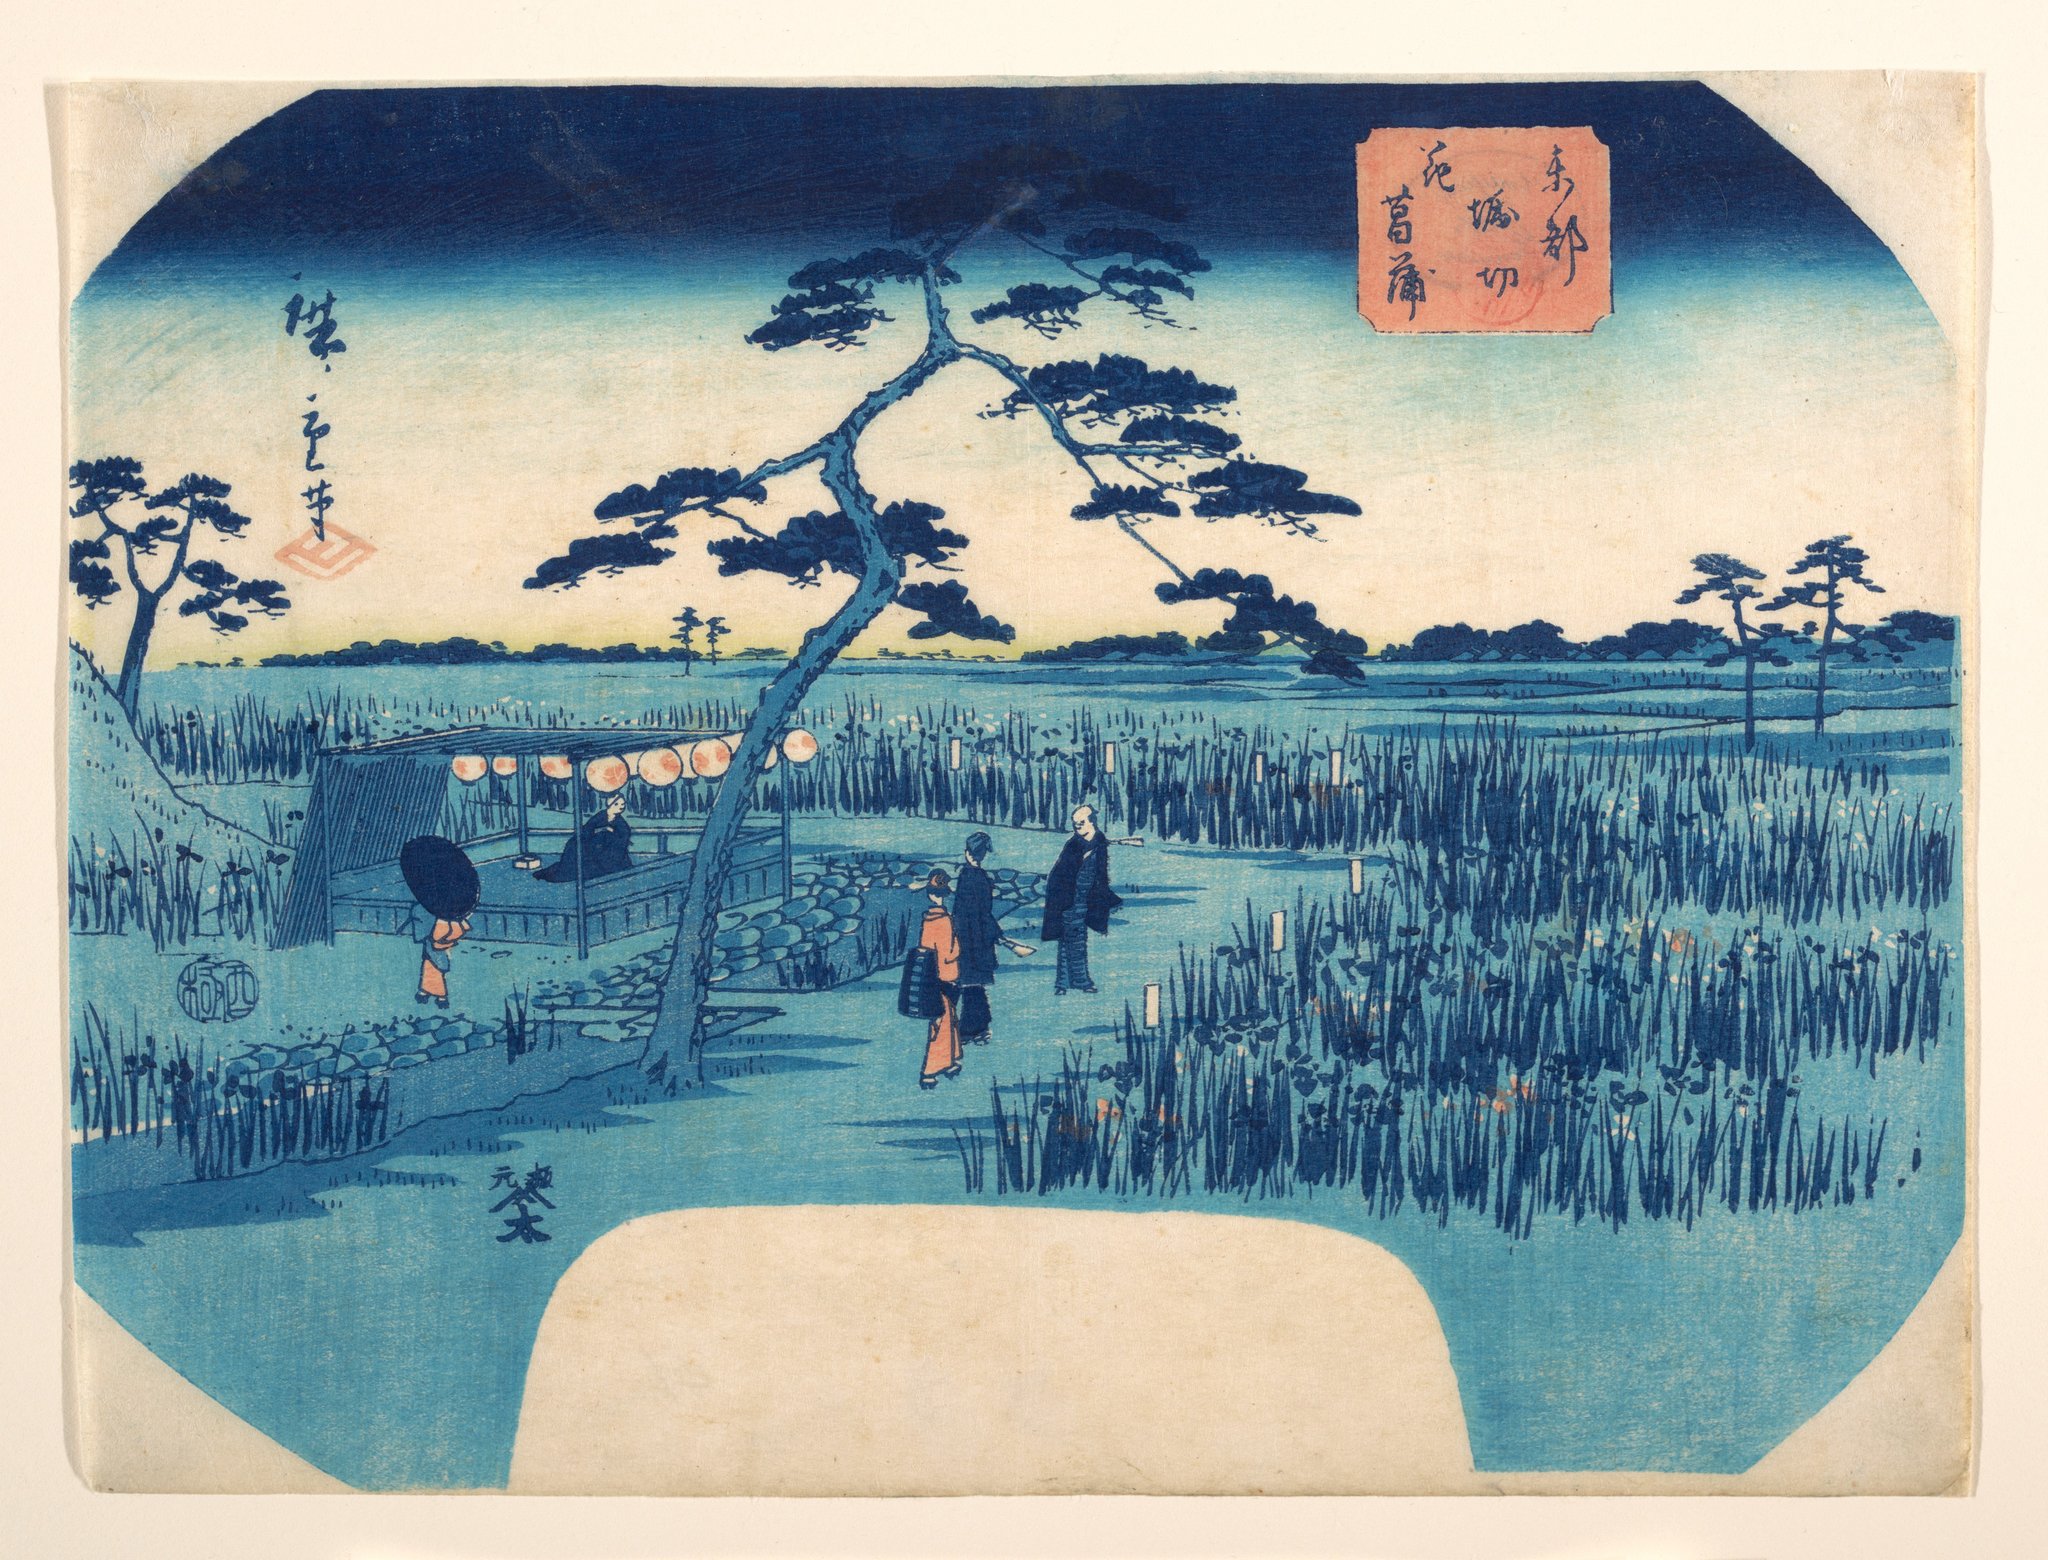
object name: print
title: View of Iris Gardens at Horikiri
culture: japanese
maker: utagawa hiroshige ii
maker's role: artist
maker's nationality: japanese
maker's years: 1826-1869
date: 1801-1900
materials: ink, paper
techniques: woodblock print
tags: gardens,men,women,trees